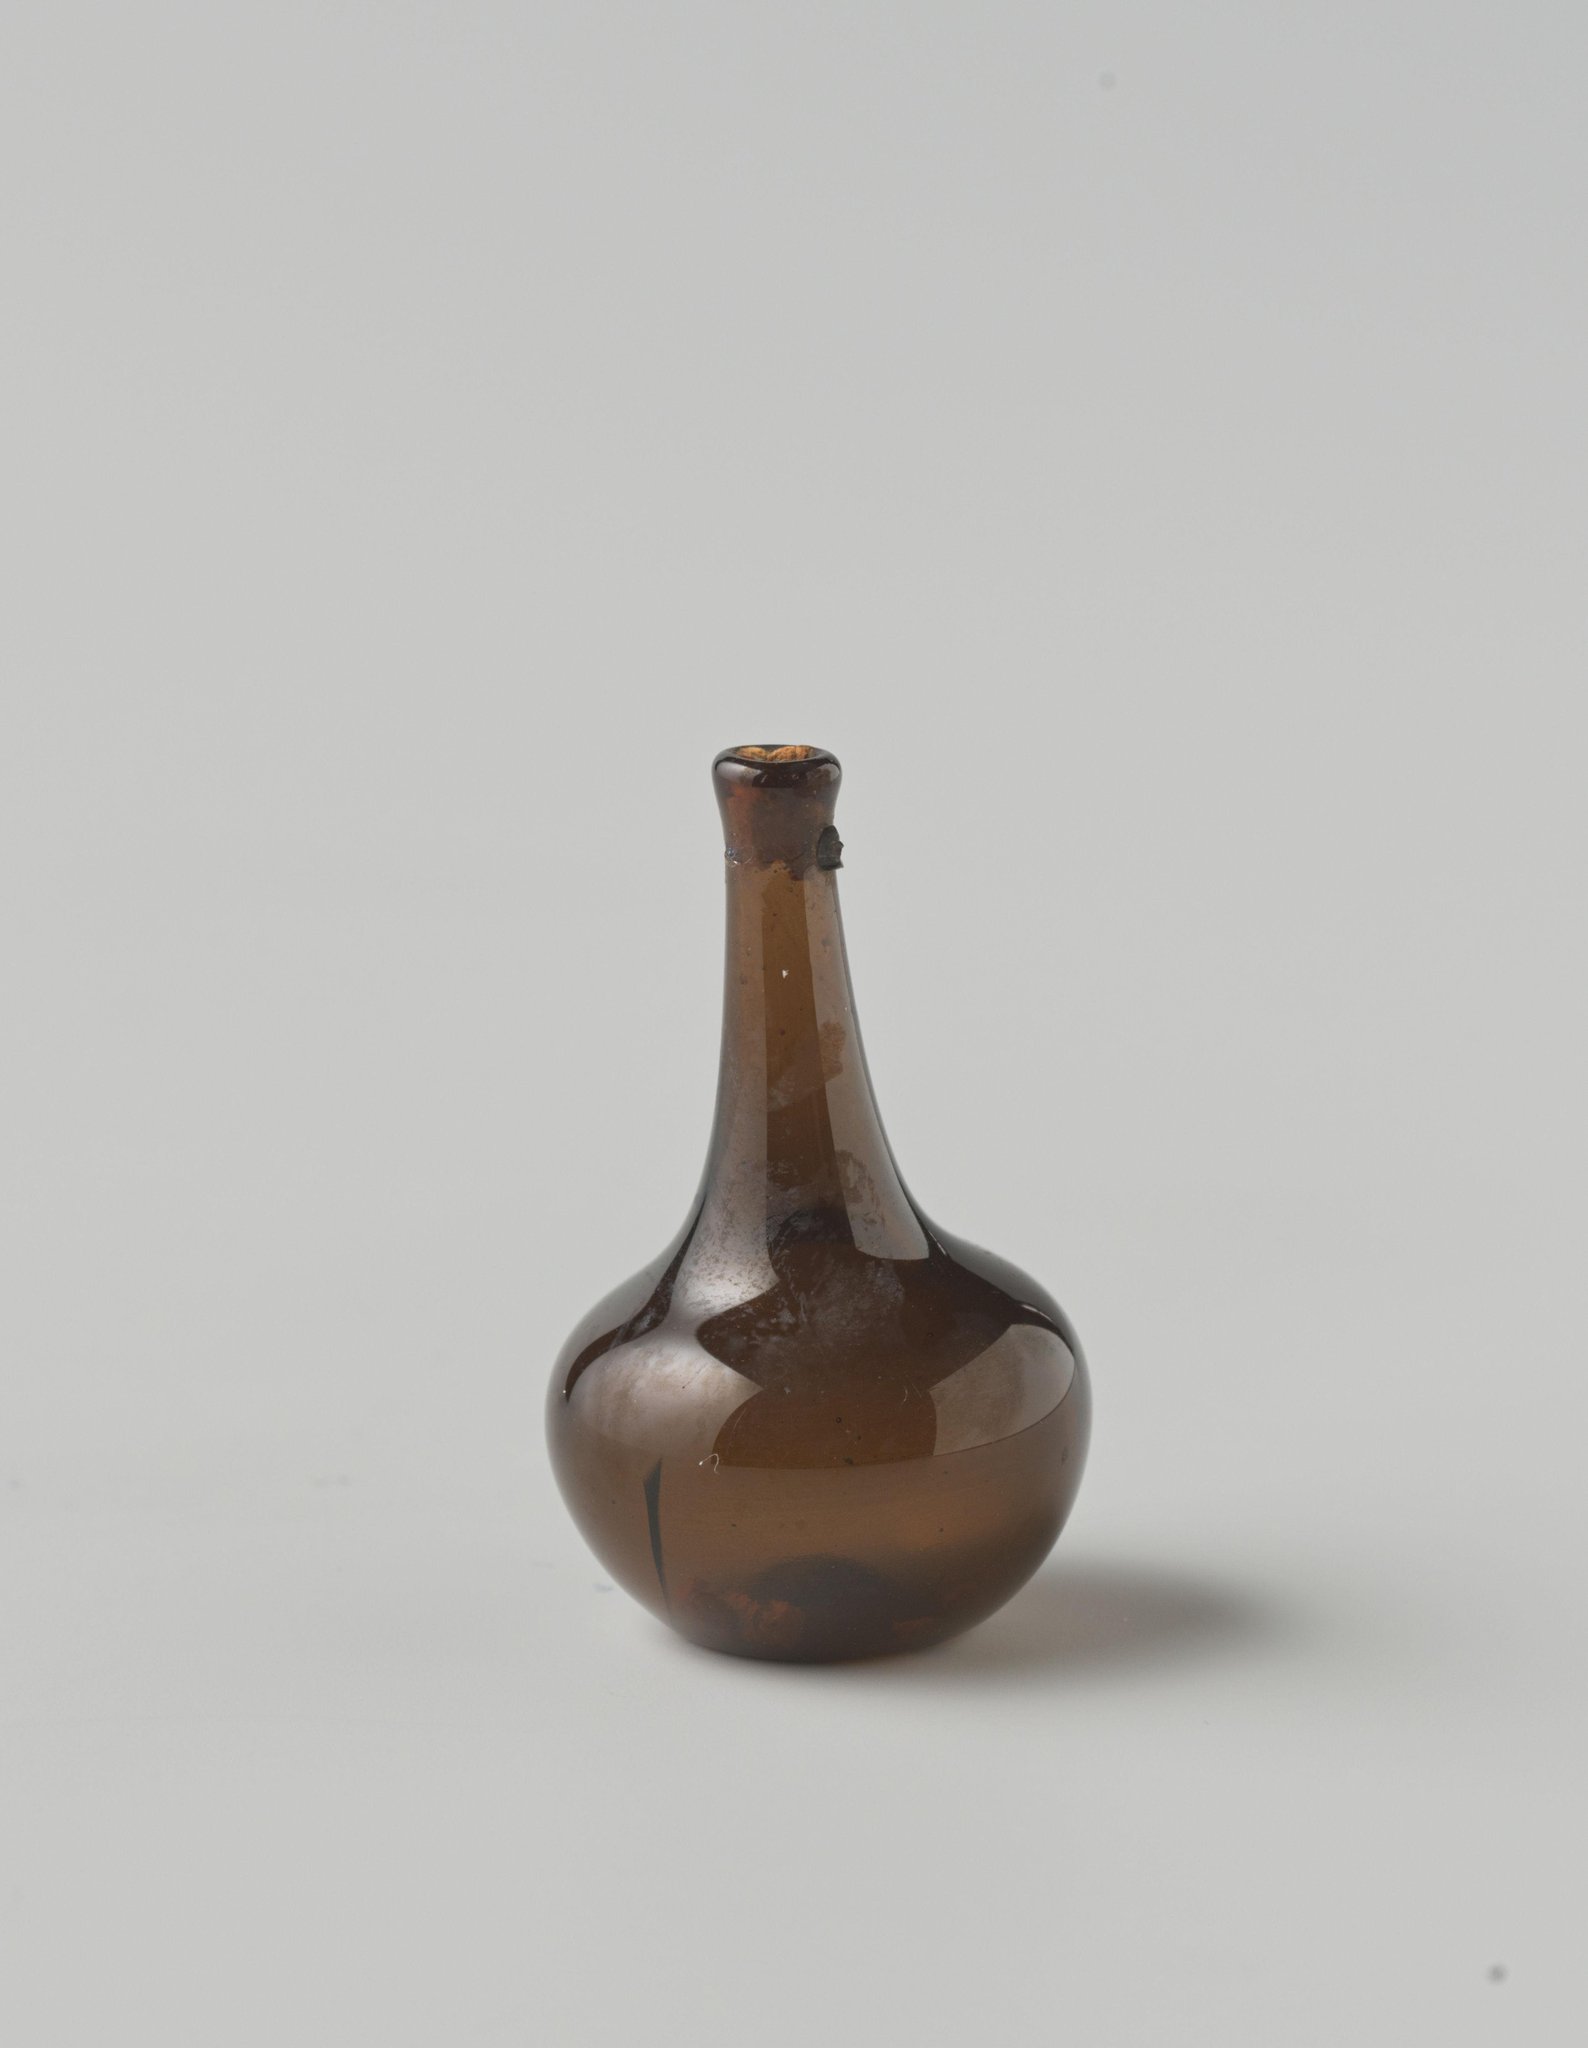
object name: miniature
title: Fles van helder azuurblauw glas; buik met ingestoken ziel, hoge hals met druipring (grotendeels afgebroken), in de halsopening een kurk.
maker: Anonymous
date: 1675-1710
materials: cork, glass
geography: amsterdam